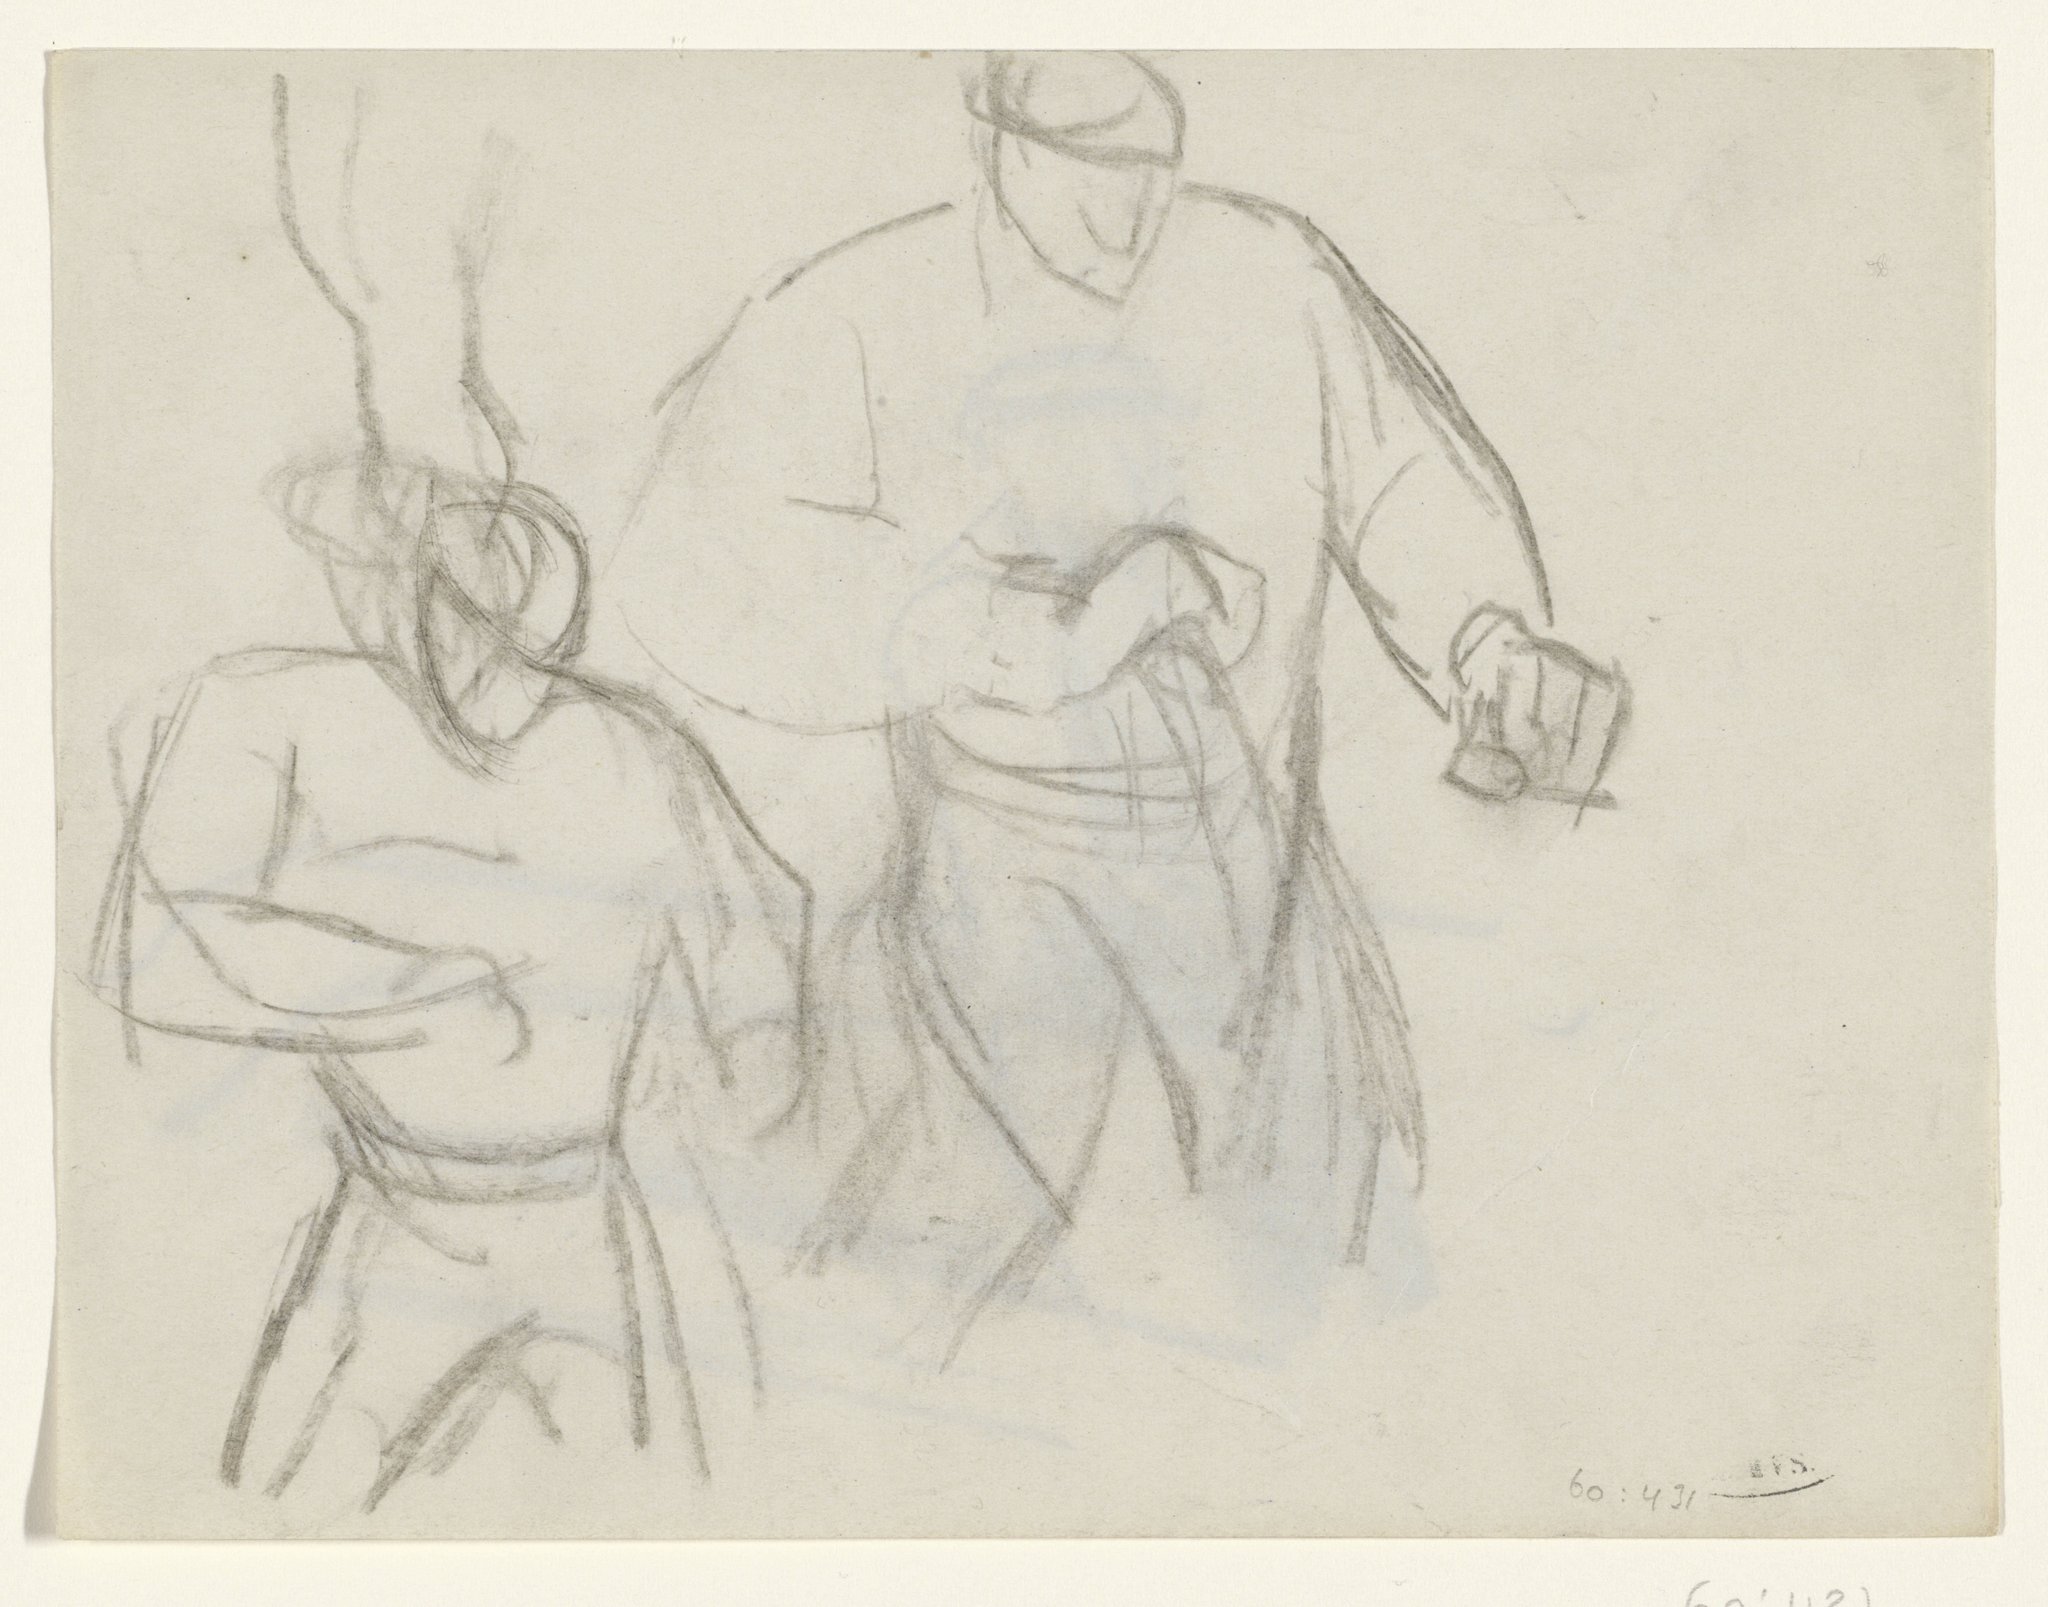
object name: drawing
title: Twee mannen met gebalde vuisten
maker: leo gestel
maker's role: draughtsman, print maker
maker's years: 1881-1941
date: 1891-1941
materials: chalk, paper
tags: adult man (+ front view)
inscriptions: collector's mark: Lugt 2228